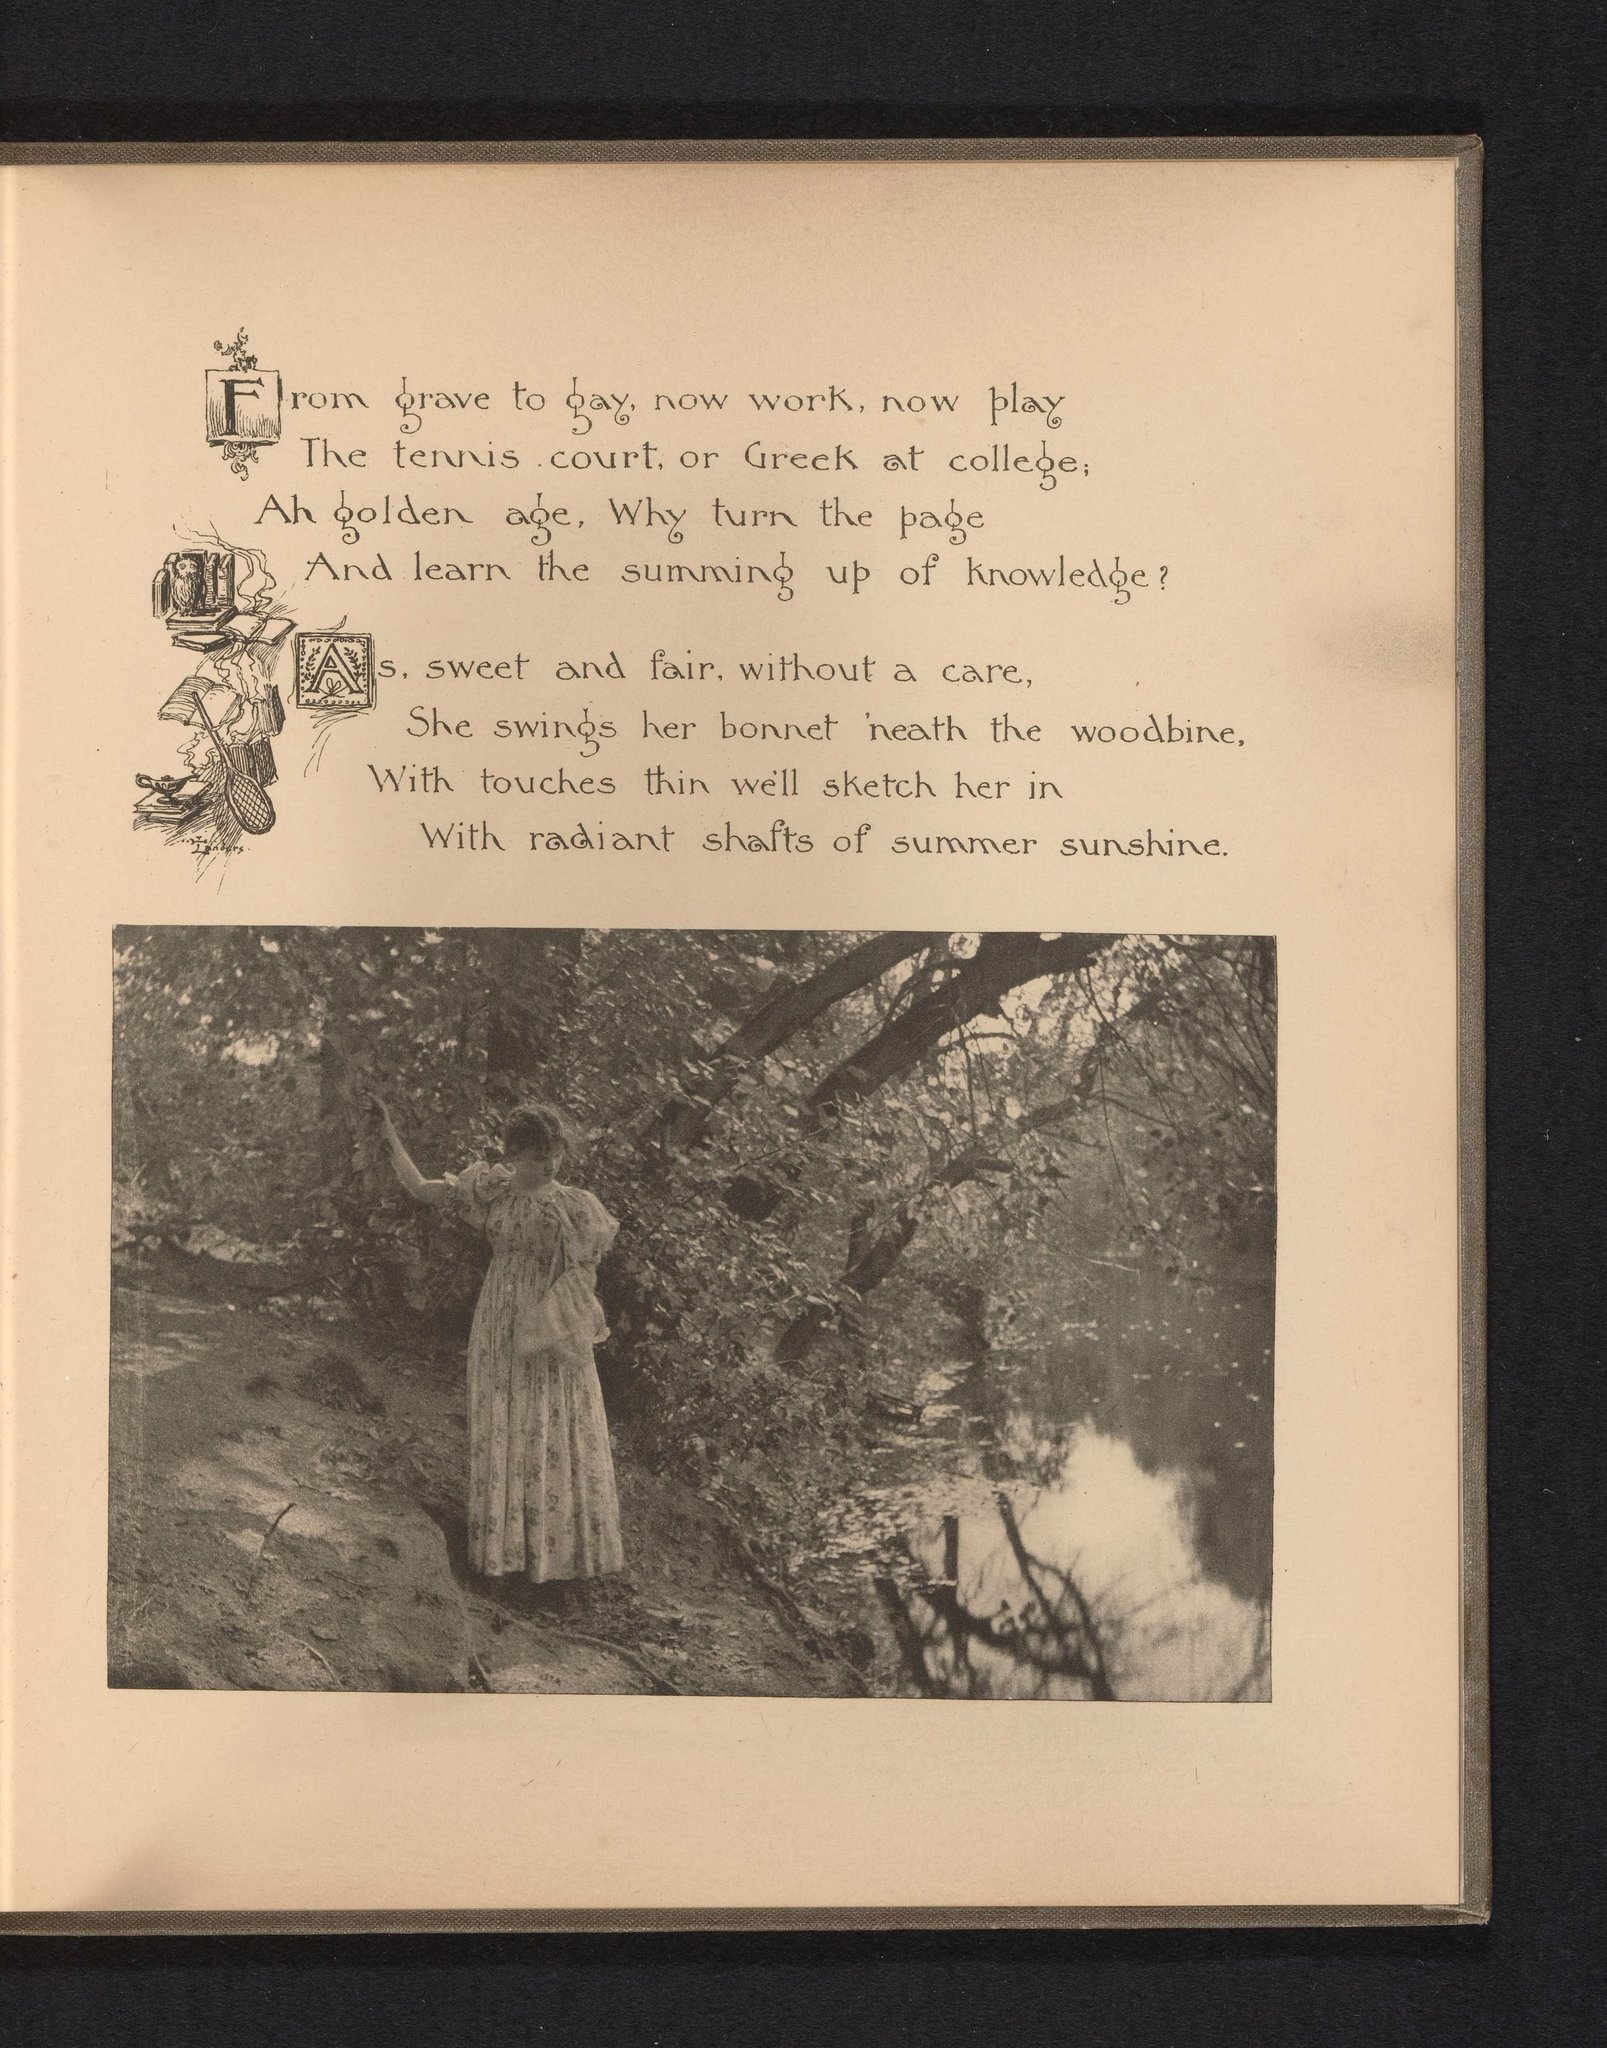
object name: photomechanical print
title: Vrouw aan een waterkant met bomen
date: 1884-1894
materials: paper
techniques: photoaquatint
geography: united states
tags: adolescent, young woman, maiden, river bank